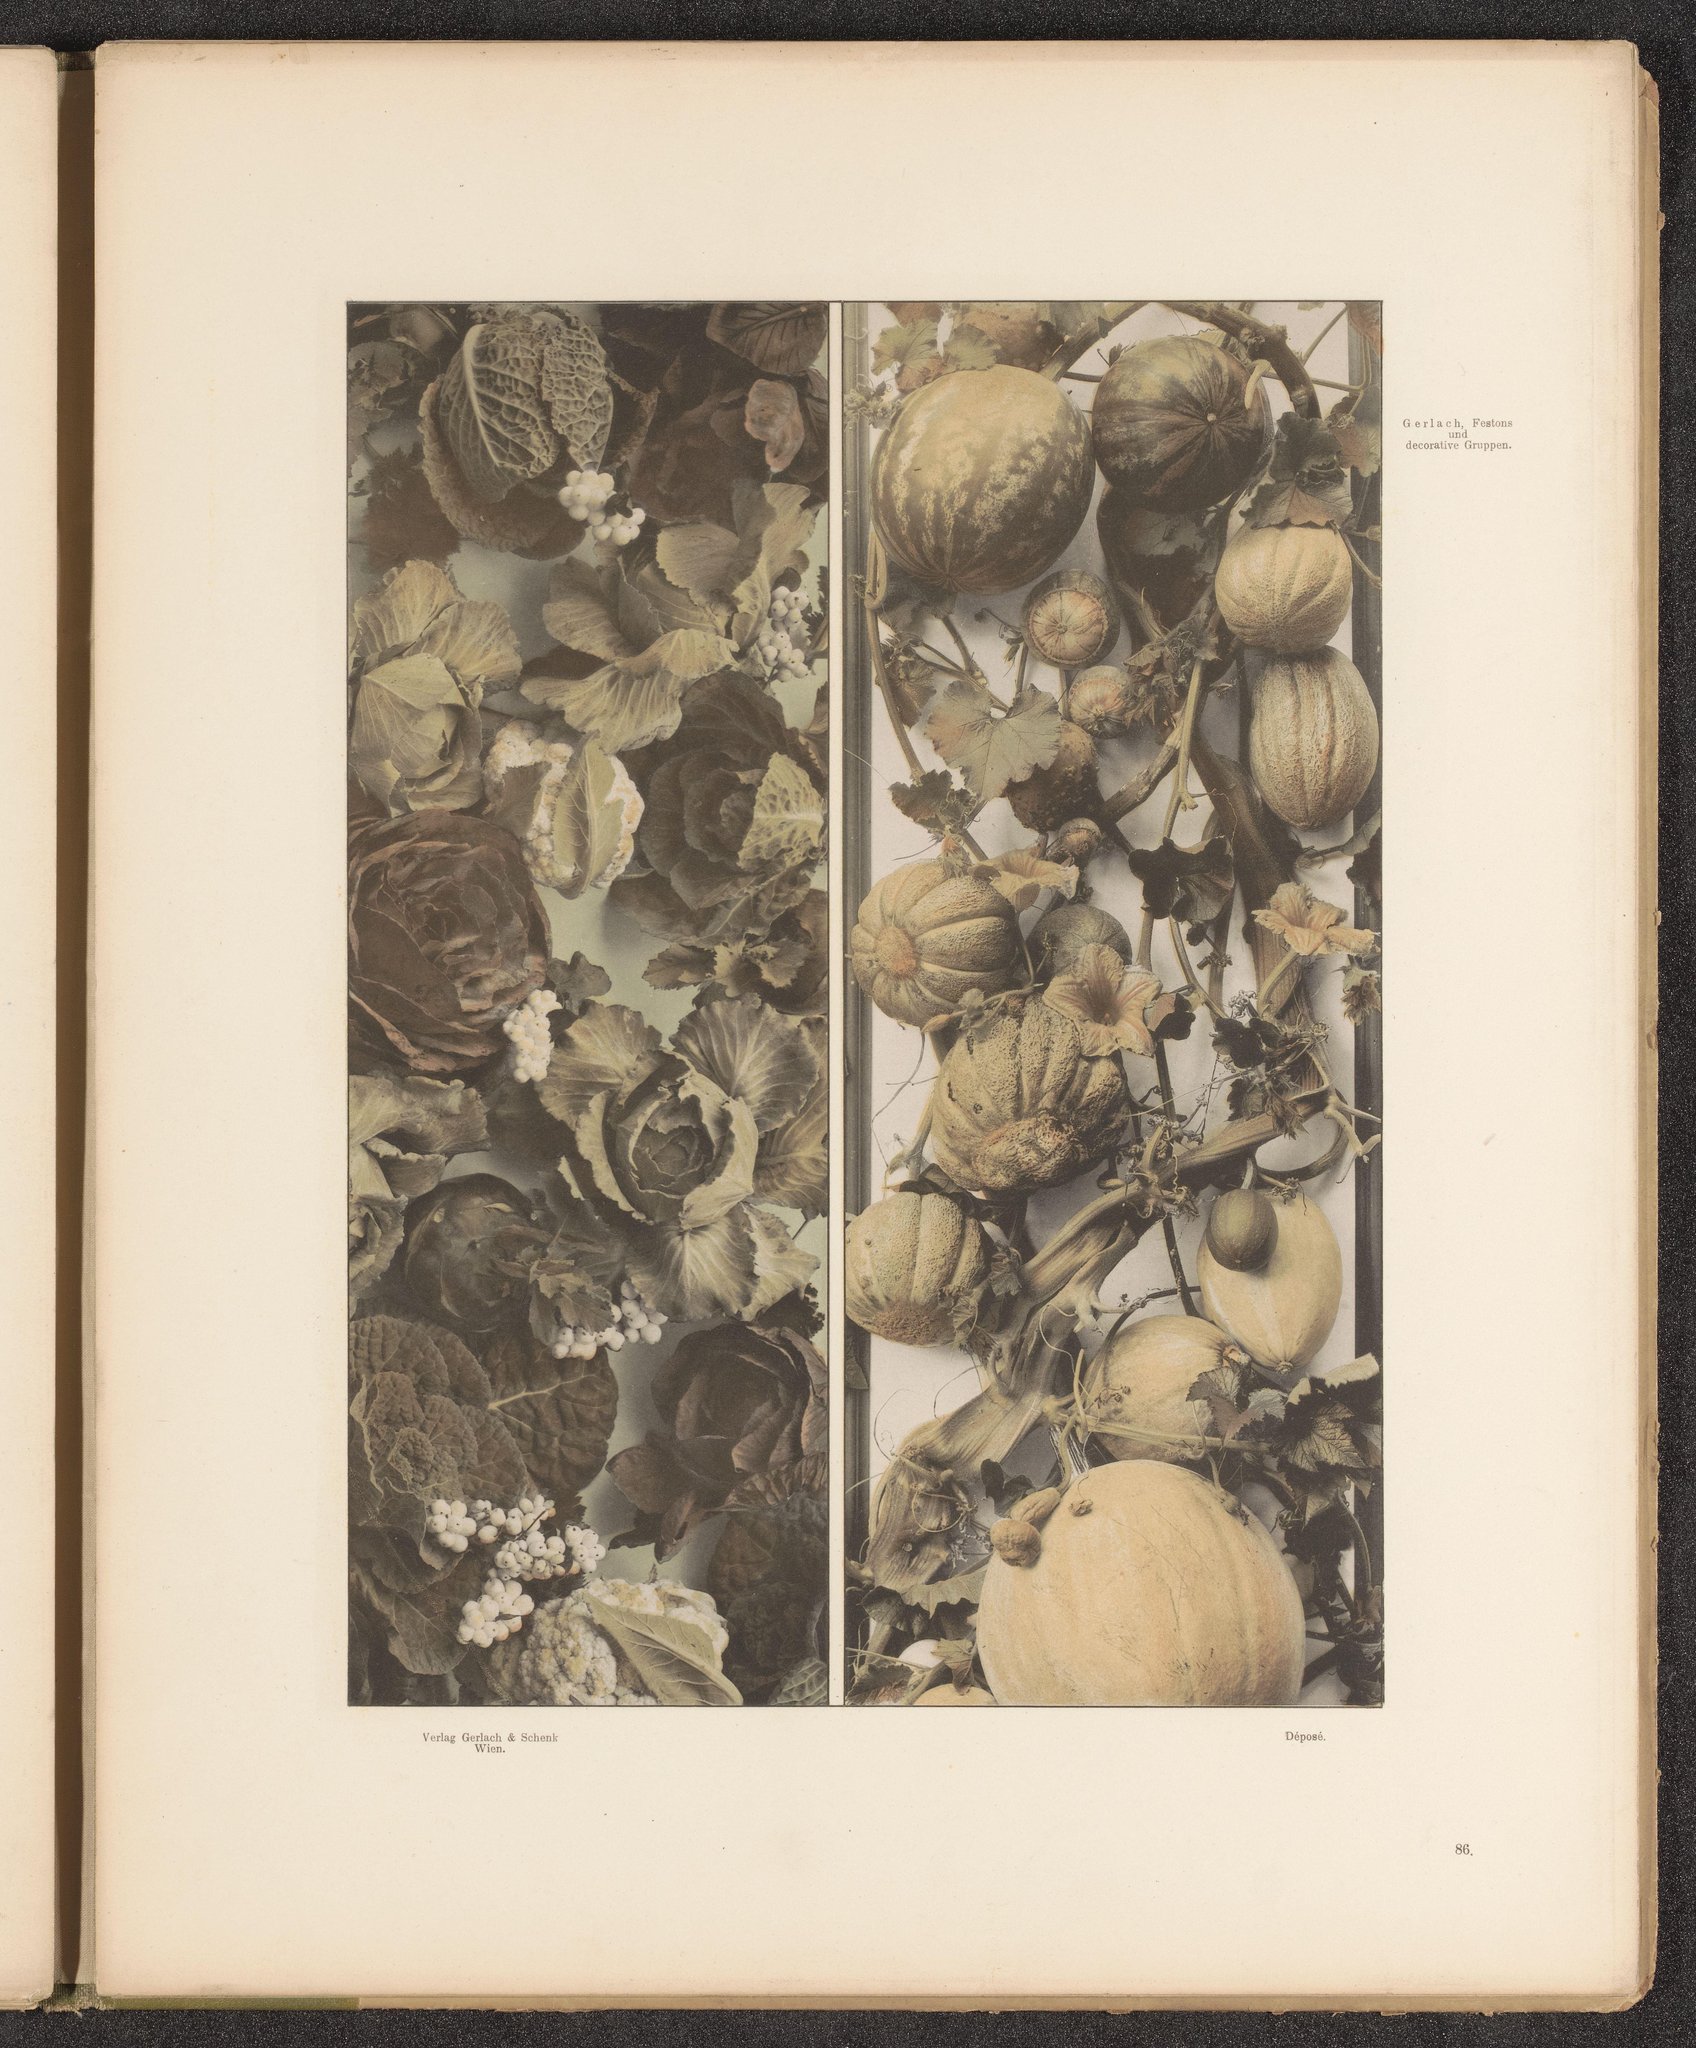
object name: page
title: Twee vlakken met bloemkolen, pompoenen en meloenen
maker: Anonymous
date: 1887-1897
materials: paper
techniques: photograph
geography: austria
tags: fruits: melon, fruits: pumpkin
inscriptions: number: ‘86.’